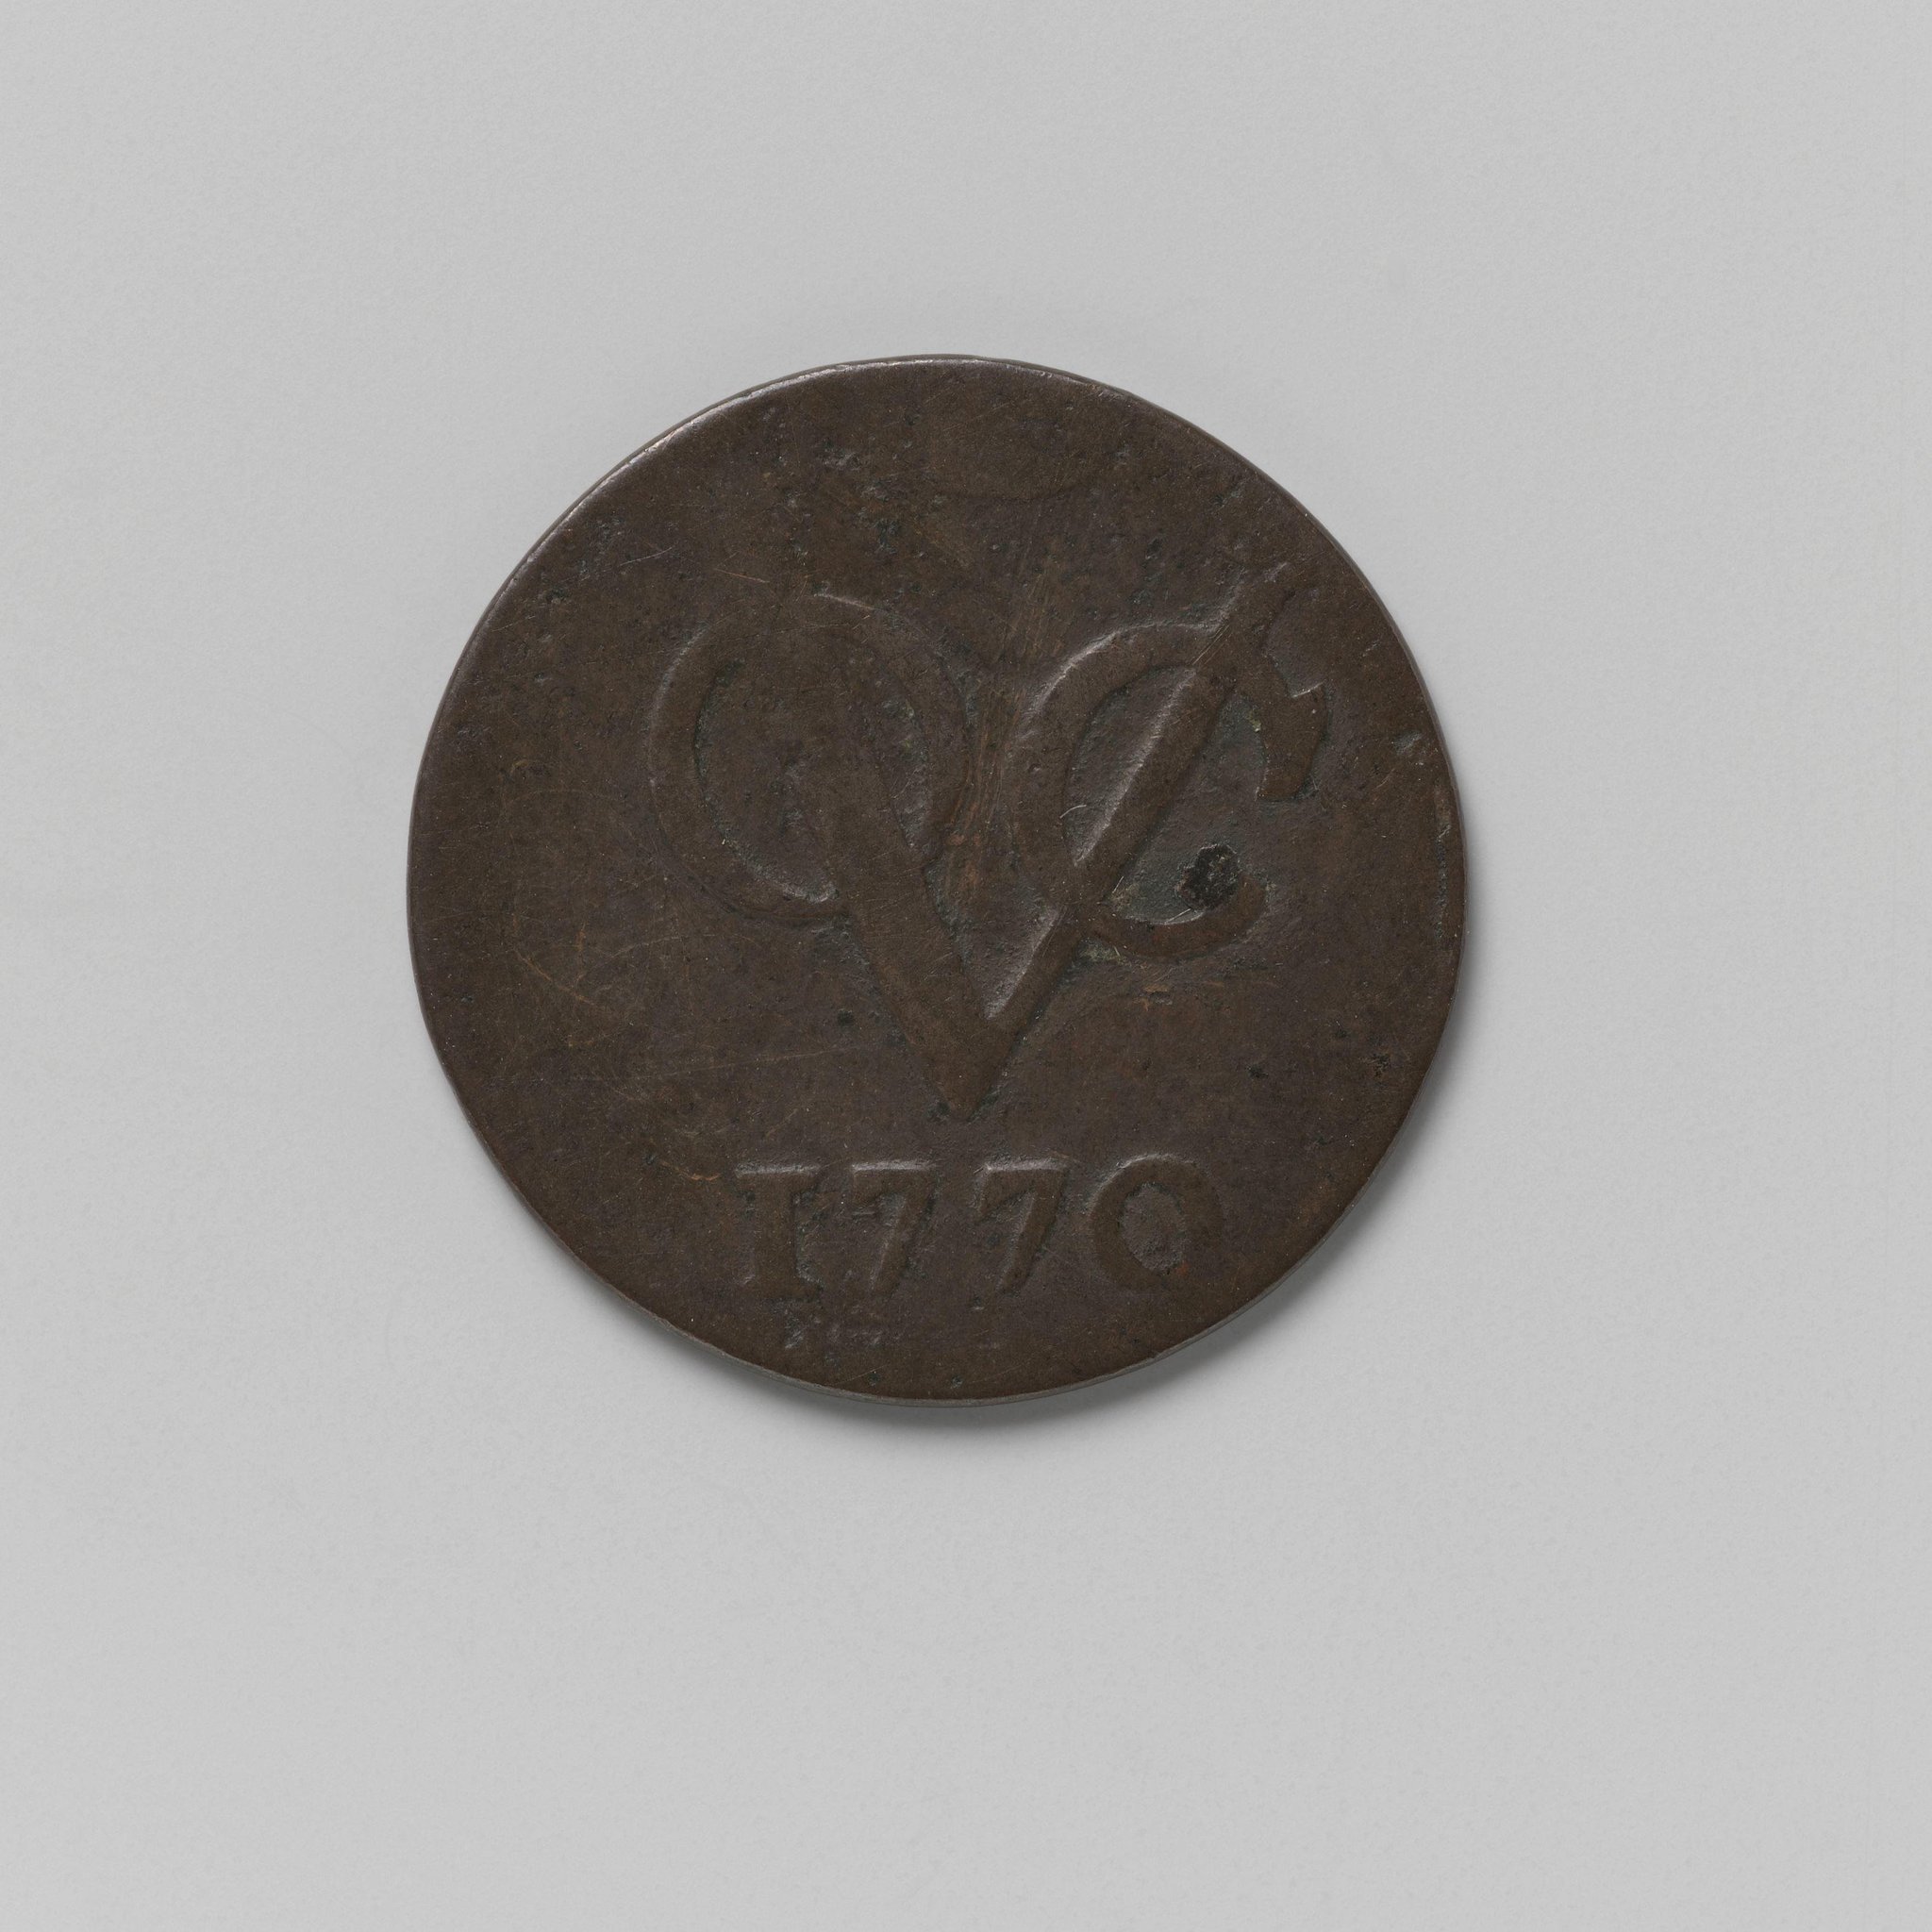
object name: coin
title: ½ duit van de VOC uit Westfriesland,1770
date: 1770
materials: copper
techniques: striking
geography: enkhuizen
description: Koperen munt. Voorzijde: gekroond wapenschild van Westfriesland. Keerzijde: monogram van de VOC, waarboven muntmeesterteken en waaronder jaartal. Gladde rand.